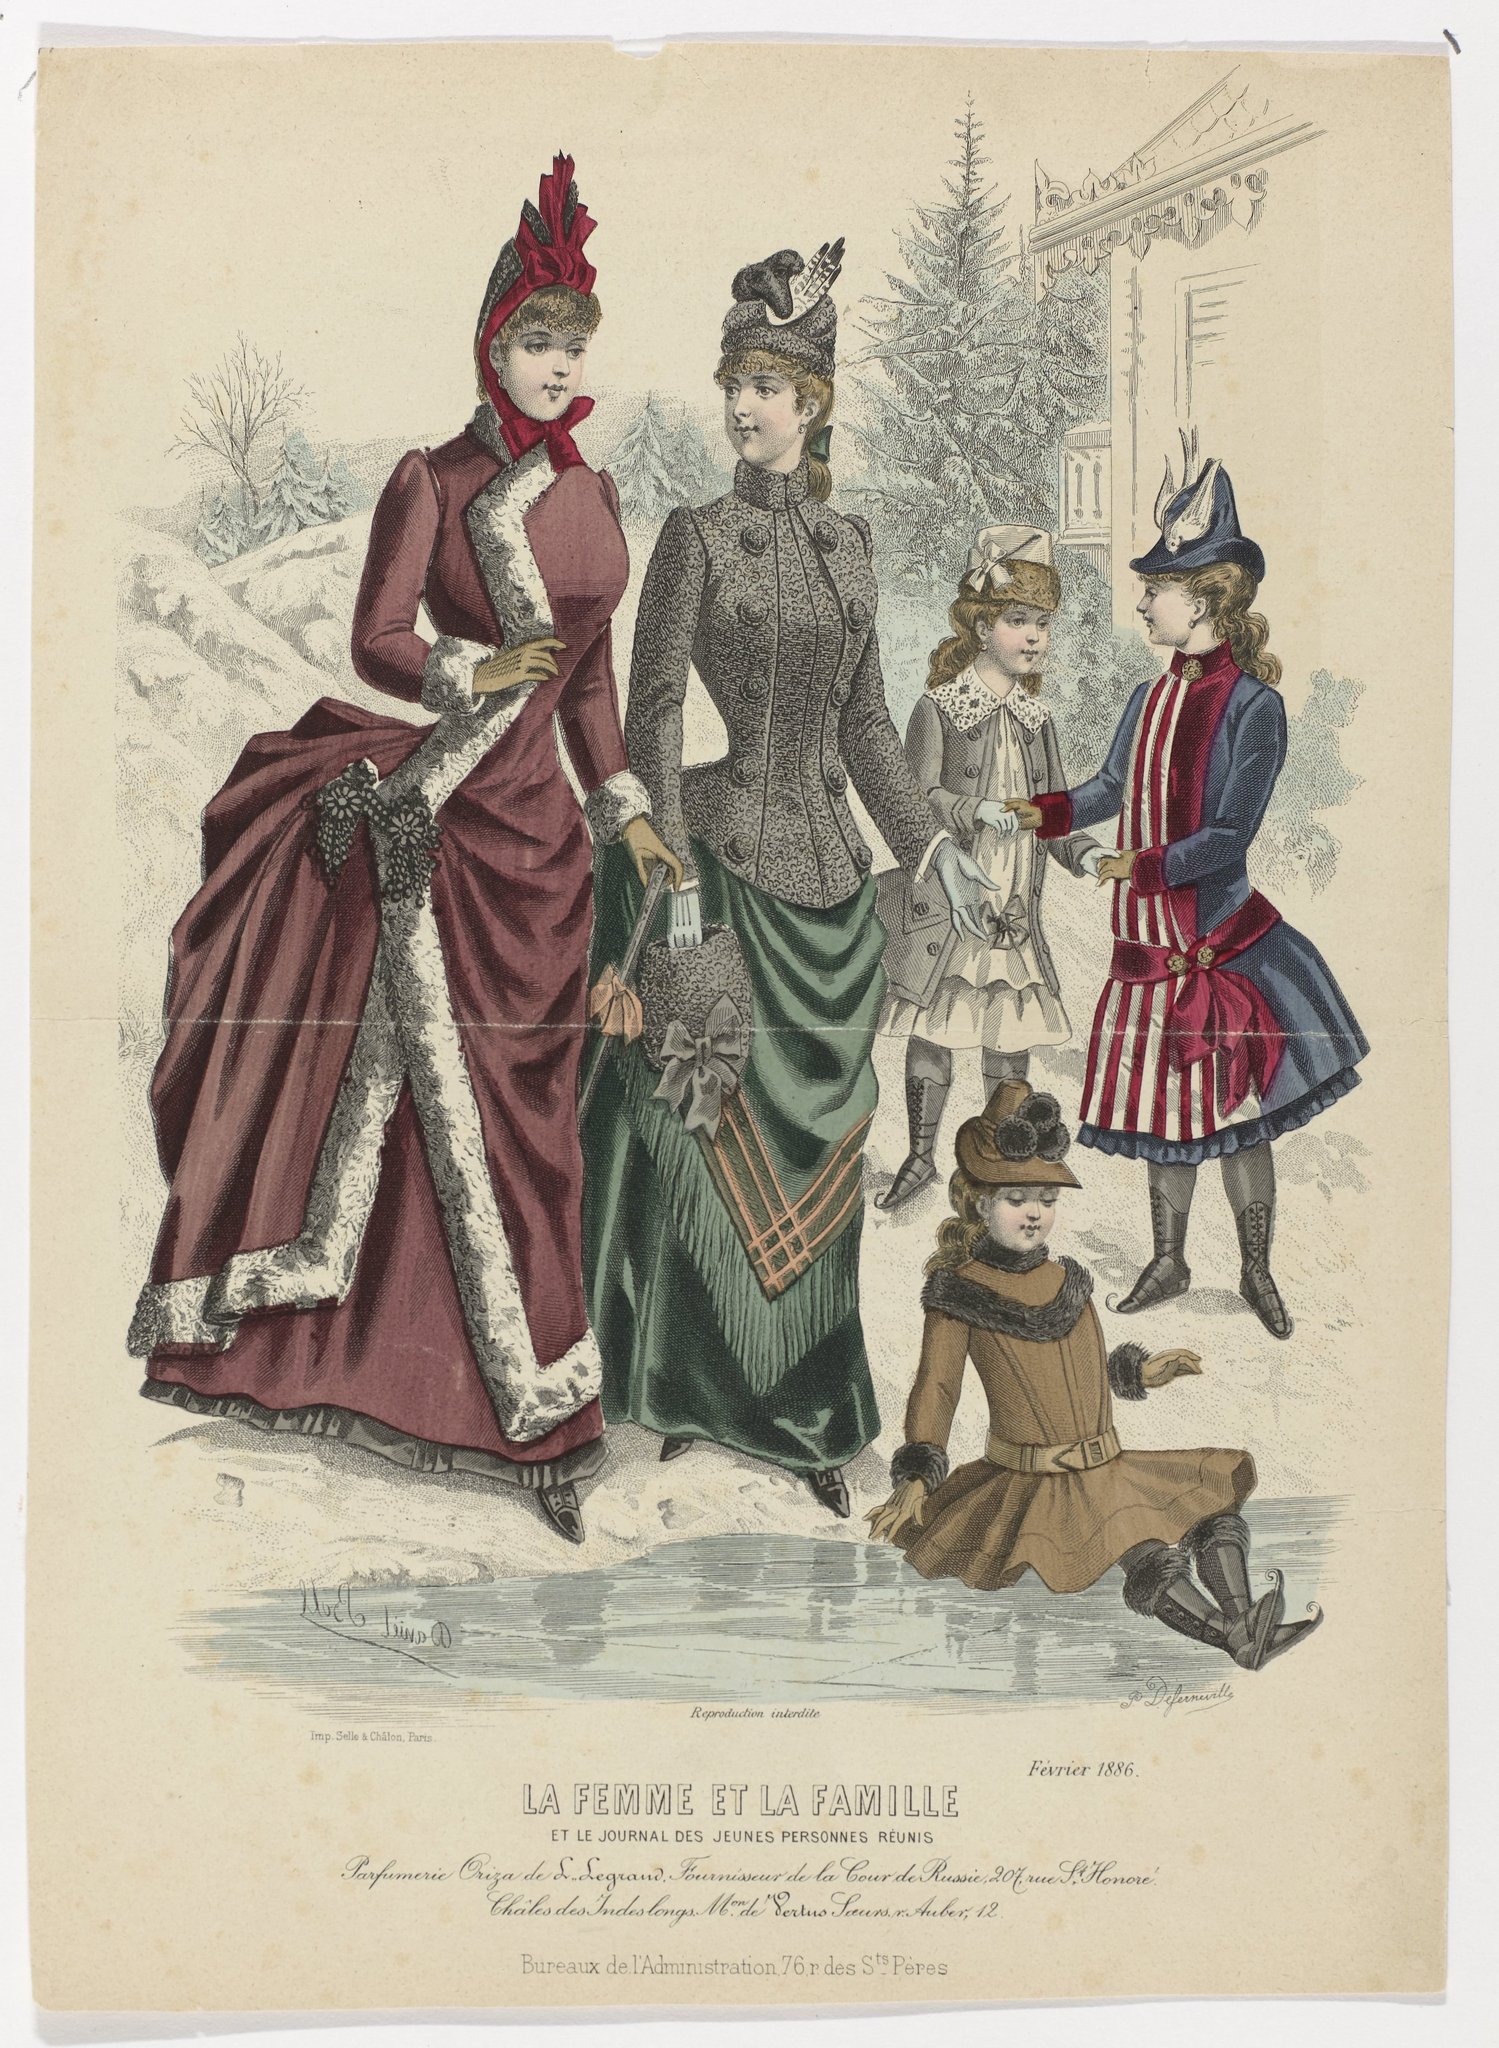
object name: fashion print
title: La Femme et la Famille et Le Journal des Jeunes Personnes Réunis, Février 1886 : Parfumerie Oriz (...)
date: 1886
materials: paper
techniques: engraving, hand coloring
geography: paris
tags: head-gear: hat (+ girls' clothes), boots (+ girls' clothes), coat (+ fur used for clothes), coat (+ women's clothes), coat (+ girls' clothes), fashion plates, head-gear: hat (+ women's clothes), skirt (+ women's clothes), dress, gown (+ women's clothes), skates (winter sports), snow, muff (+ fur used for clothes), head-gear: hat (+ feathers used for clothes), muff (+ women's clothes), head-gear: cap (+ fur used for clothes), dress, gown (+ girls' clothes)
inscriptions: title: ‘LA FEMME ET LA FAMILLE / ET LE JOURNAL DES JEUNES PERSONNES RÉUNIS’, address: ‘Bureaux de l'Administration, 76, r. des Sts Pères’, caption: ‘Parfumerie Oriza de L Legrand, Fournisseur de la Cour de Russie, 207, rue St Honoré. Châles des Indes longs, Mon de Vertus Soeurs,r. Auber, 12.’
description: Twee vrouwen en drie meisjes in de sneeuw, in winterkleding. De meisjes hebben schaatsen omgebonden, één van hen zit op het ijs. Onder de voorstelling enkele regels reclametekst voor verschillende producten. Prent uit het modetijdschrift La Femme et la Famille (1867-1905).